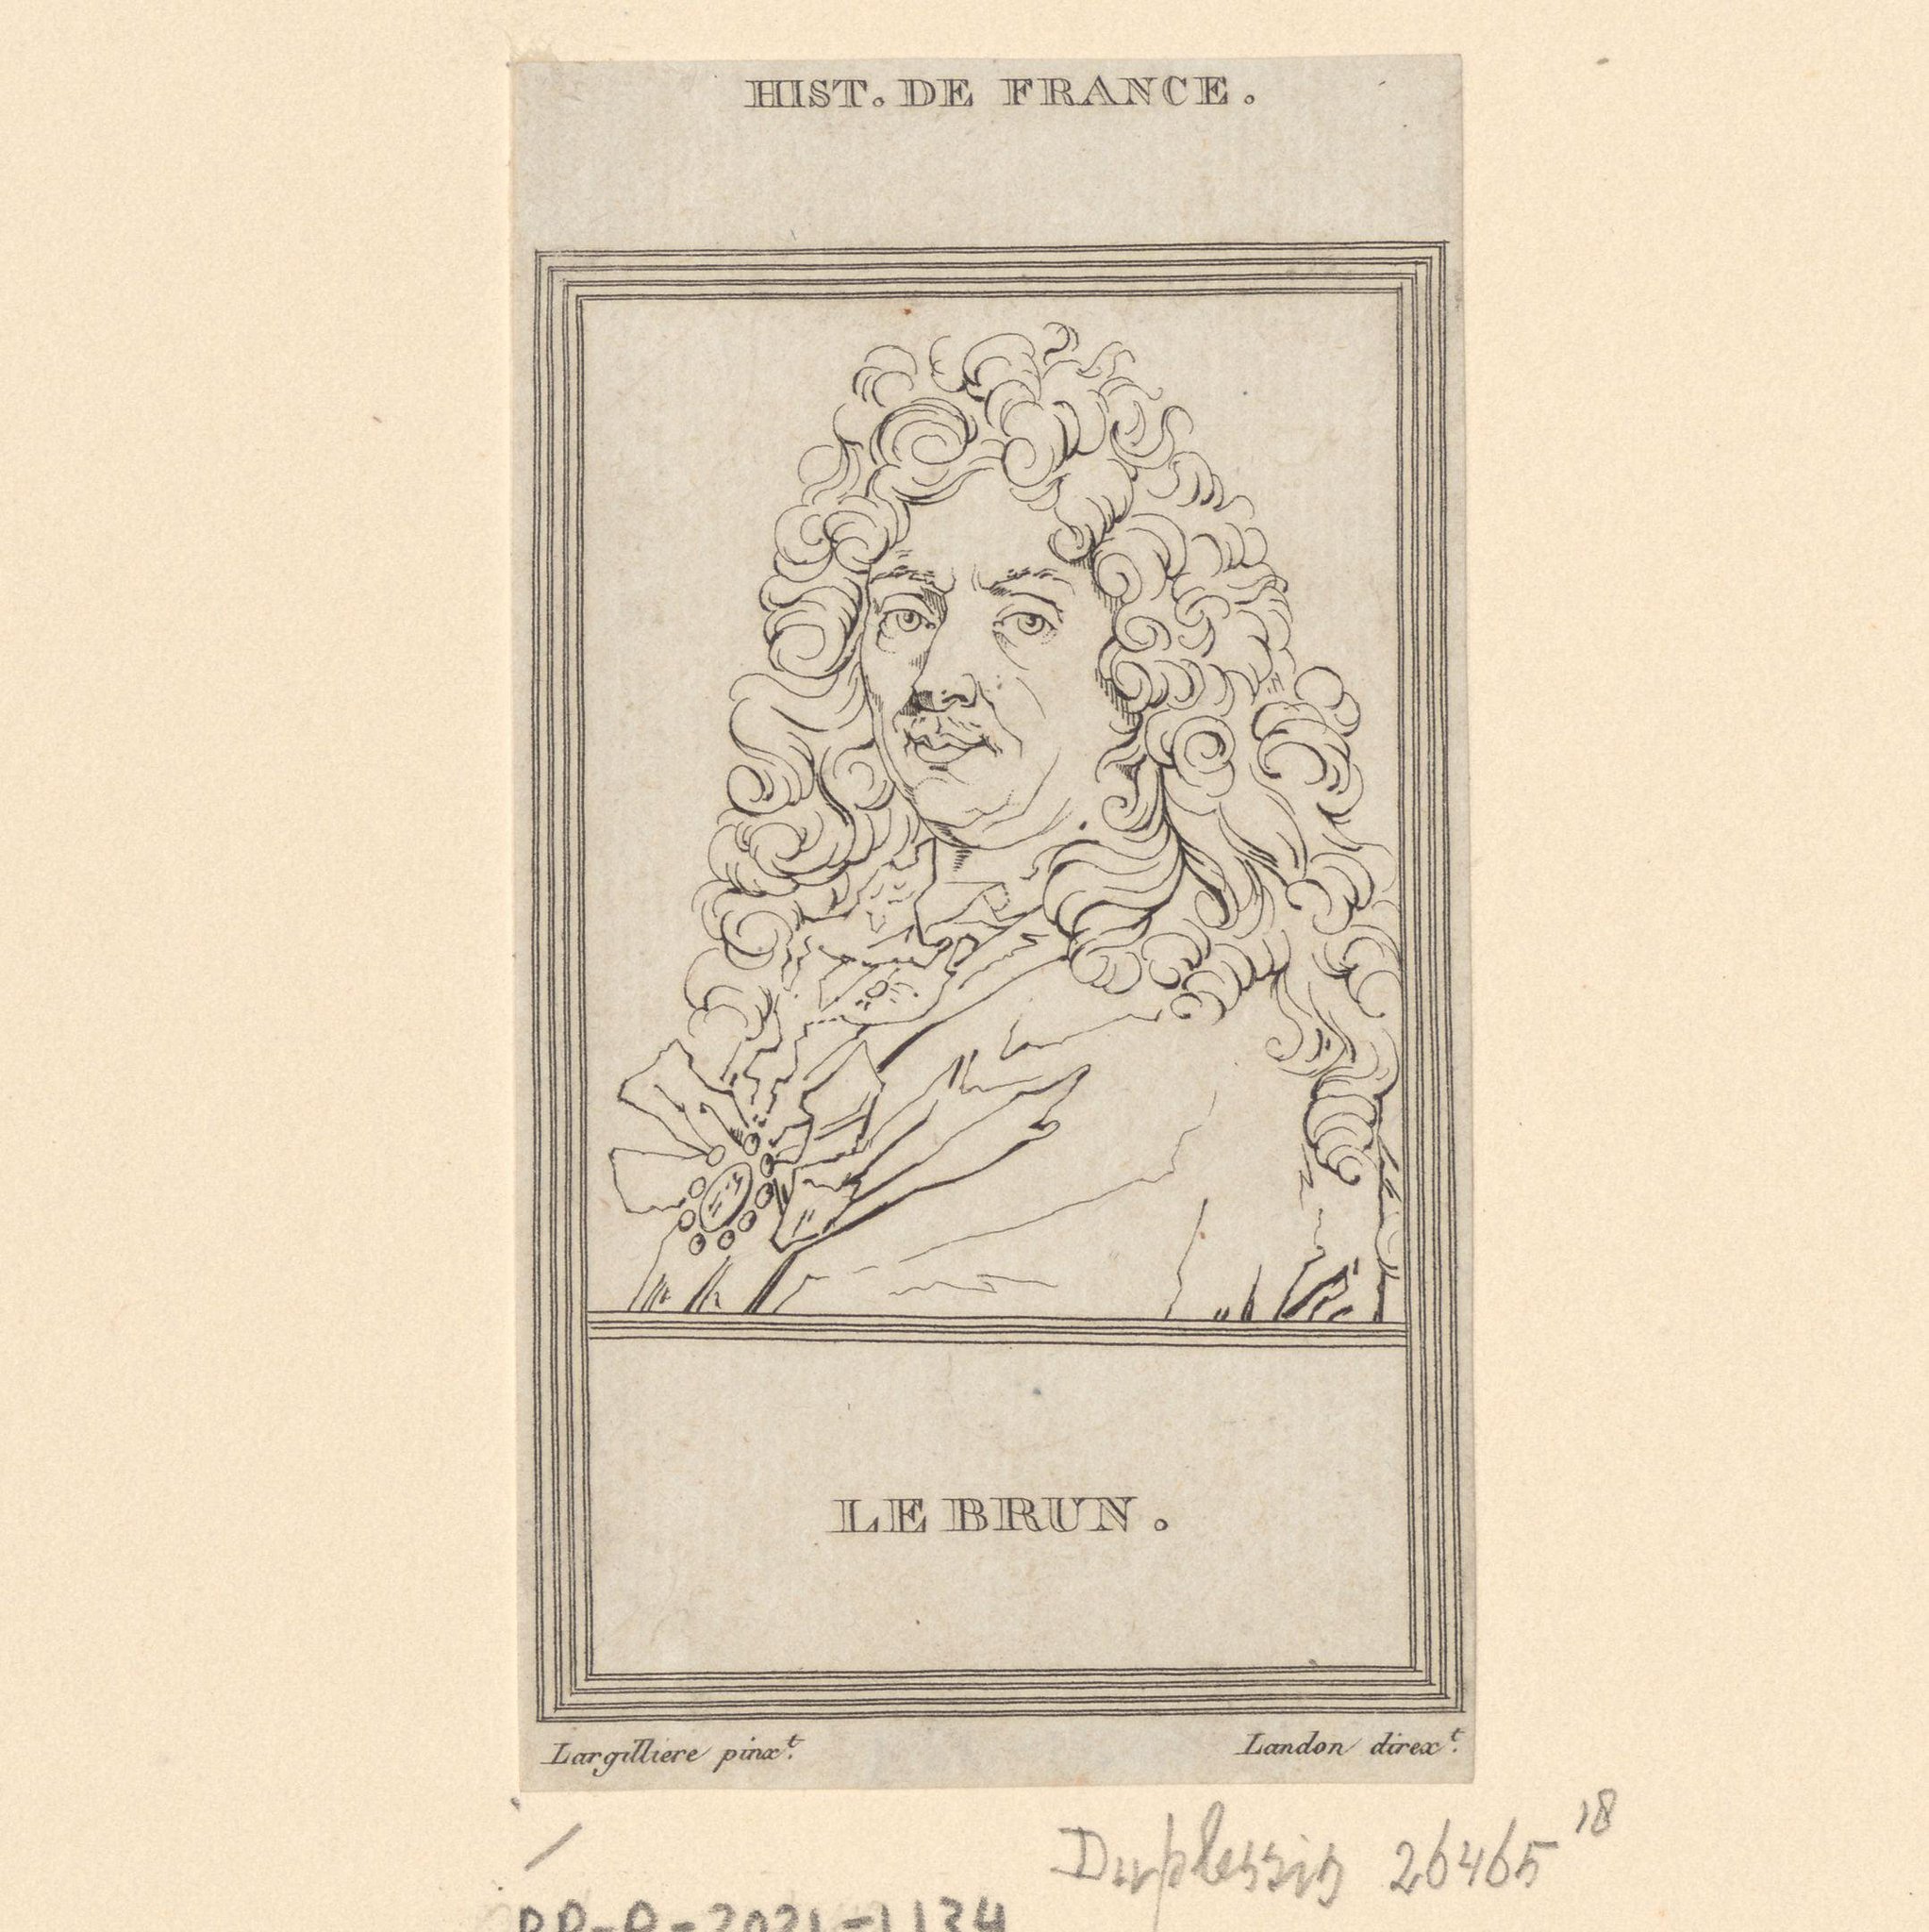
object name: print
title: Portret van Charles Le Brun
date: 1805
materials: paper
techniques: etching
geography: france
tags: paris, print maker, draughtsman, charles le brun, historical persons, portrait, self-portrait of painter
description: Prent waarschijnlijk uit: Galerie historique des hommes les plus celebres de tous les nations (...). Parijs: Charles Paul Landon, 1805, dl. 4.